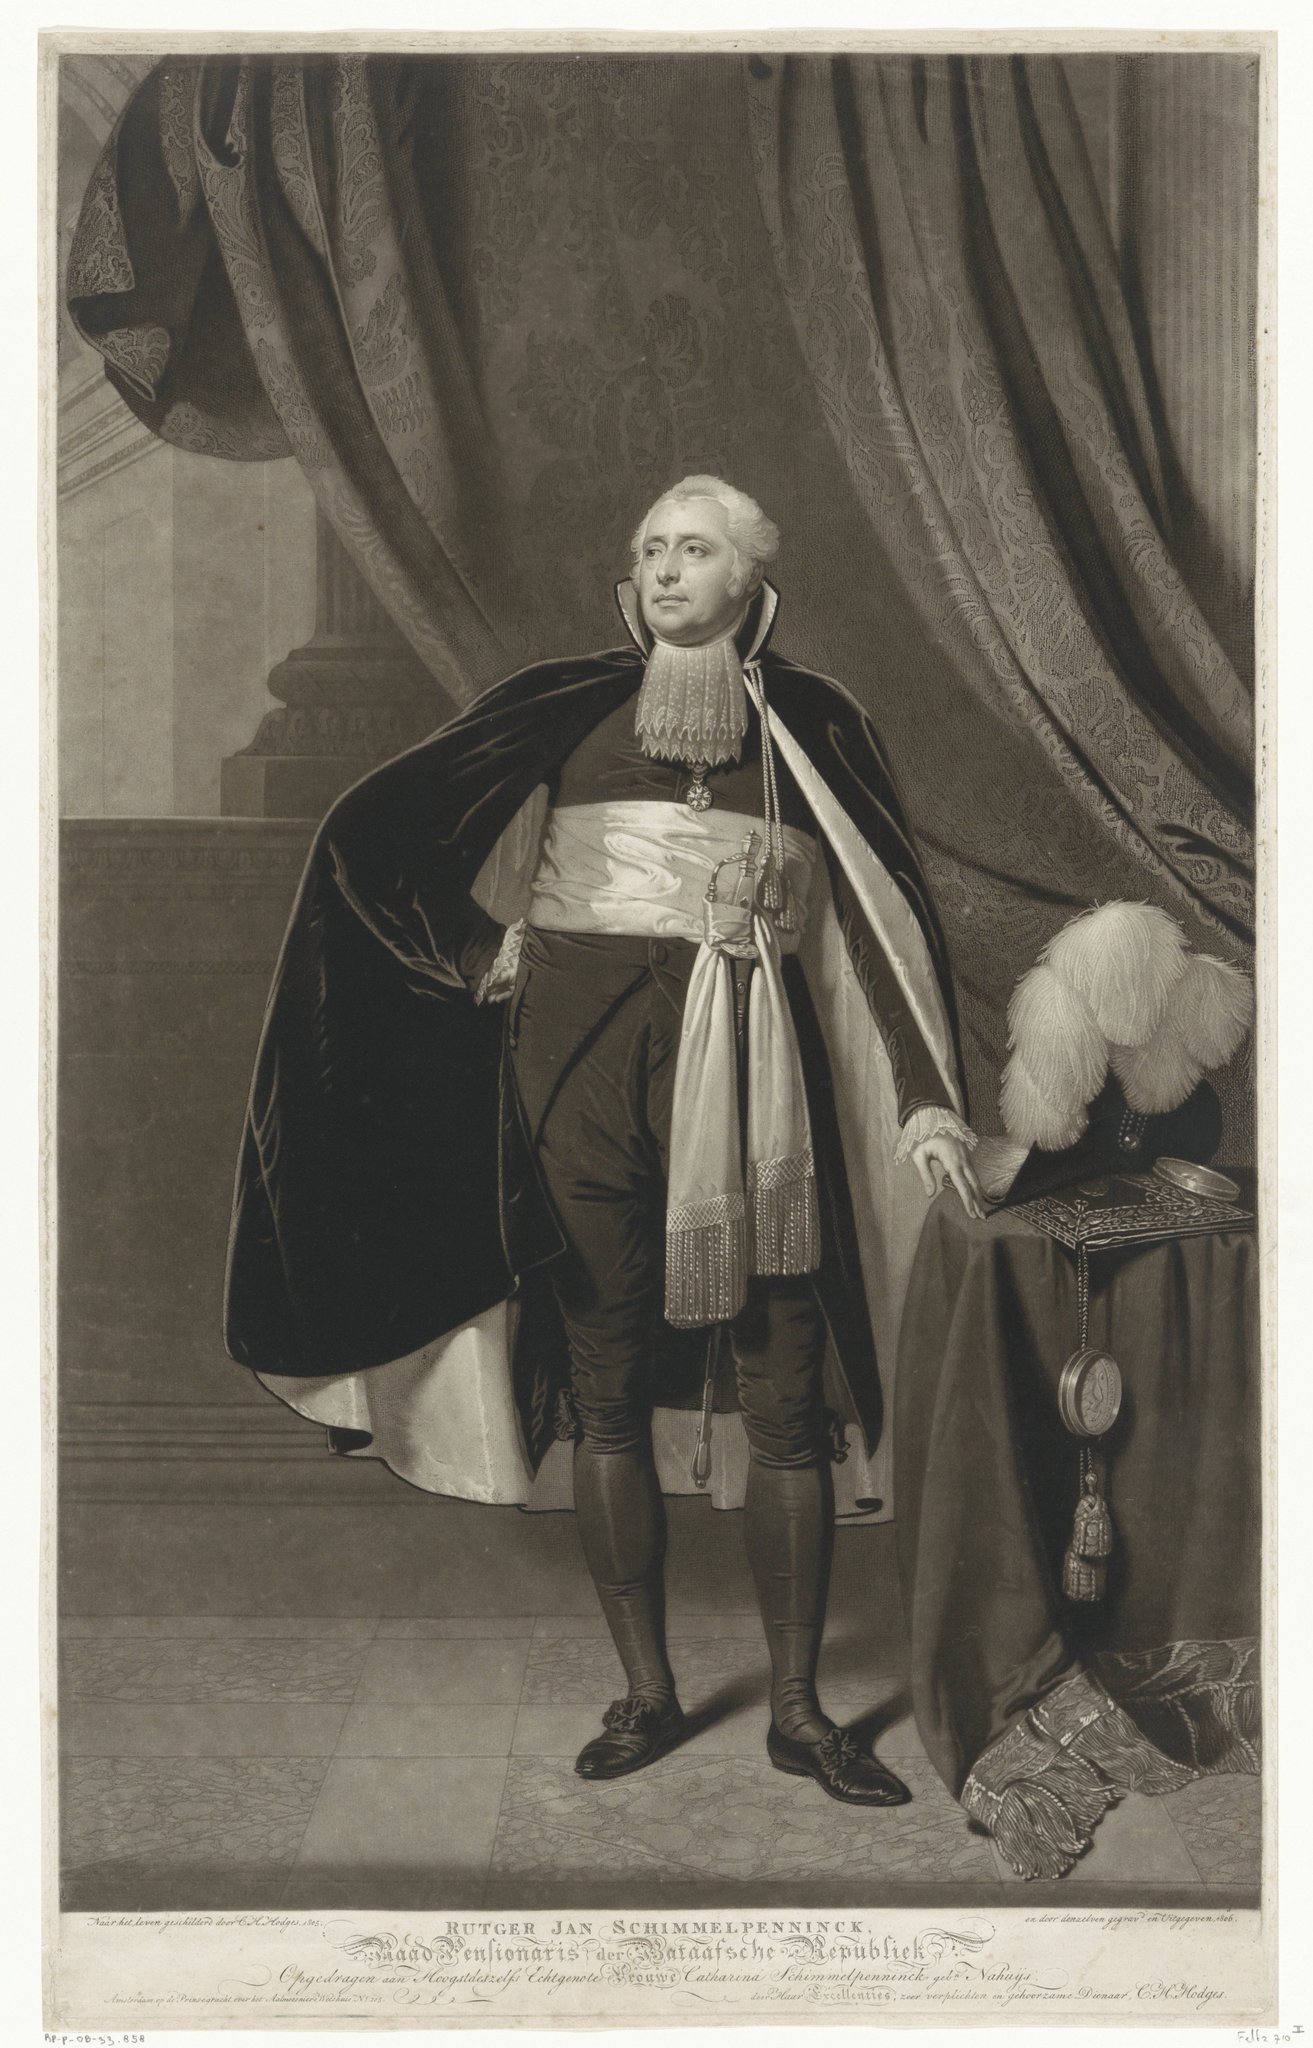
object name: print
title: Portret van Rutger Jan Schimmelpenninck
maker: charles howard hodges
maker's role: draughtsman, painter, print maker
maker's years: 1764-1837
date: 1806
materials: paper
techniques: mezzotint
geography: amsterdam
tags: deventer, amsterdam, rutger jan schimmelpenninck (1761-1825), head-gear: bicorne, bicorn (+ men's clothes)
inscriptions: collector's mark: Lugt 2228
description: Rutger Jan Schimmelpenninck, raadpensionaris van de Bataafse Republiek. Hij staat naast een tafeltje waarop een steek met pluimen en een boek liggen.